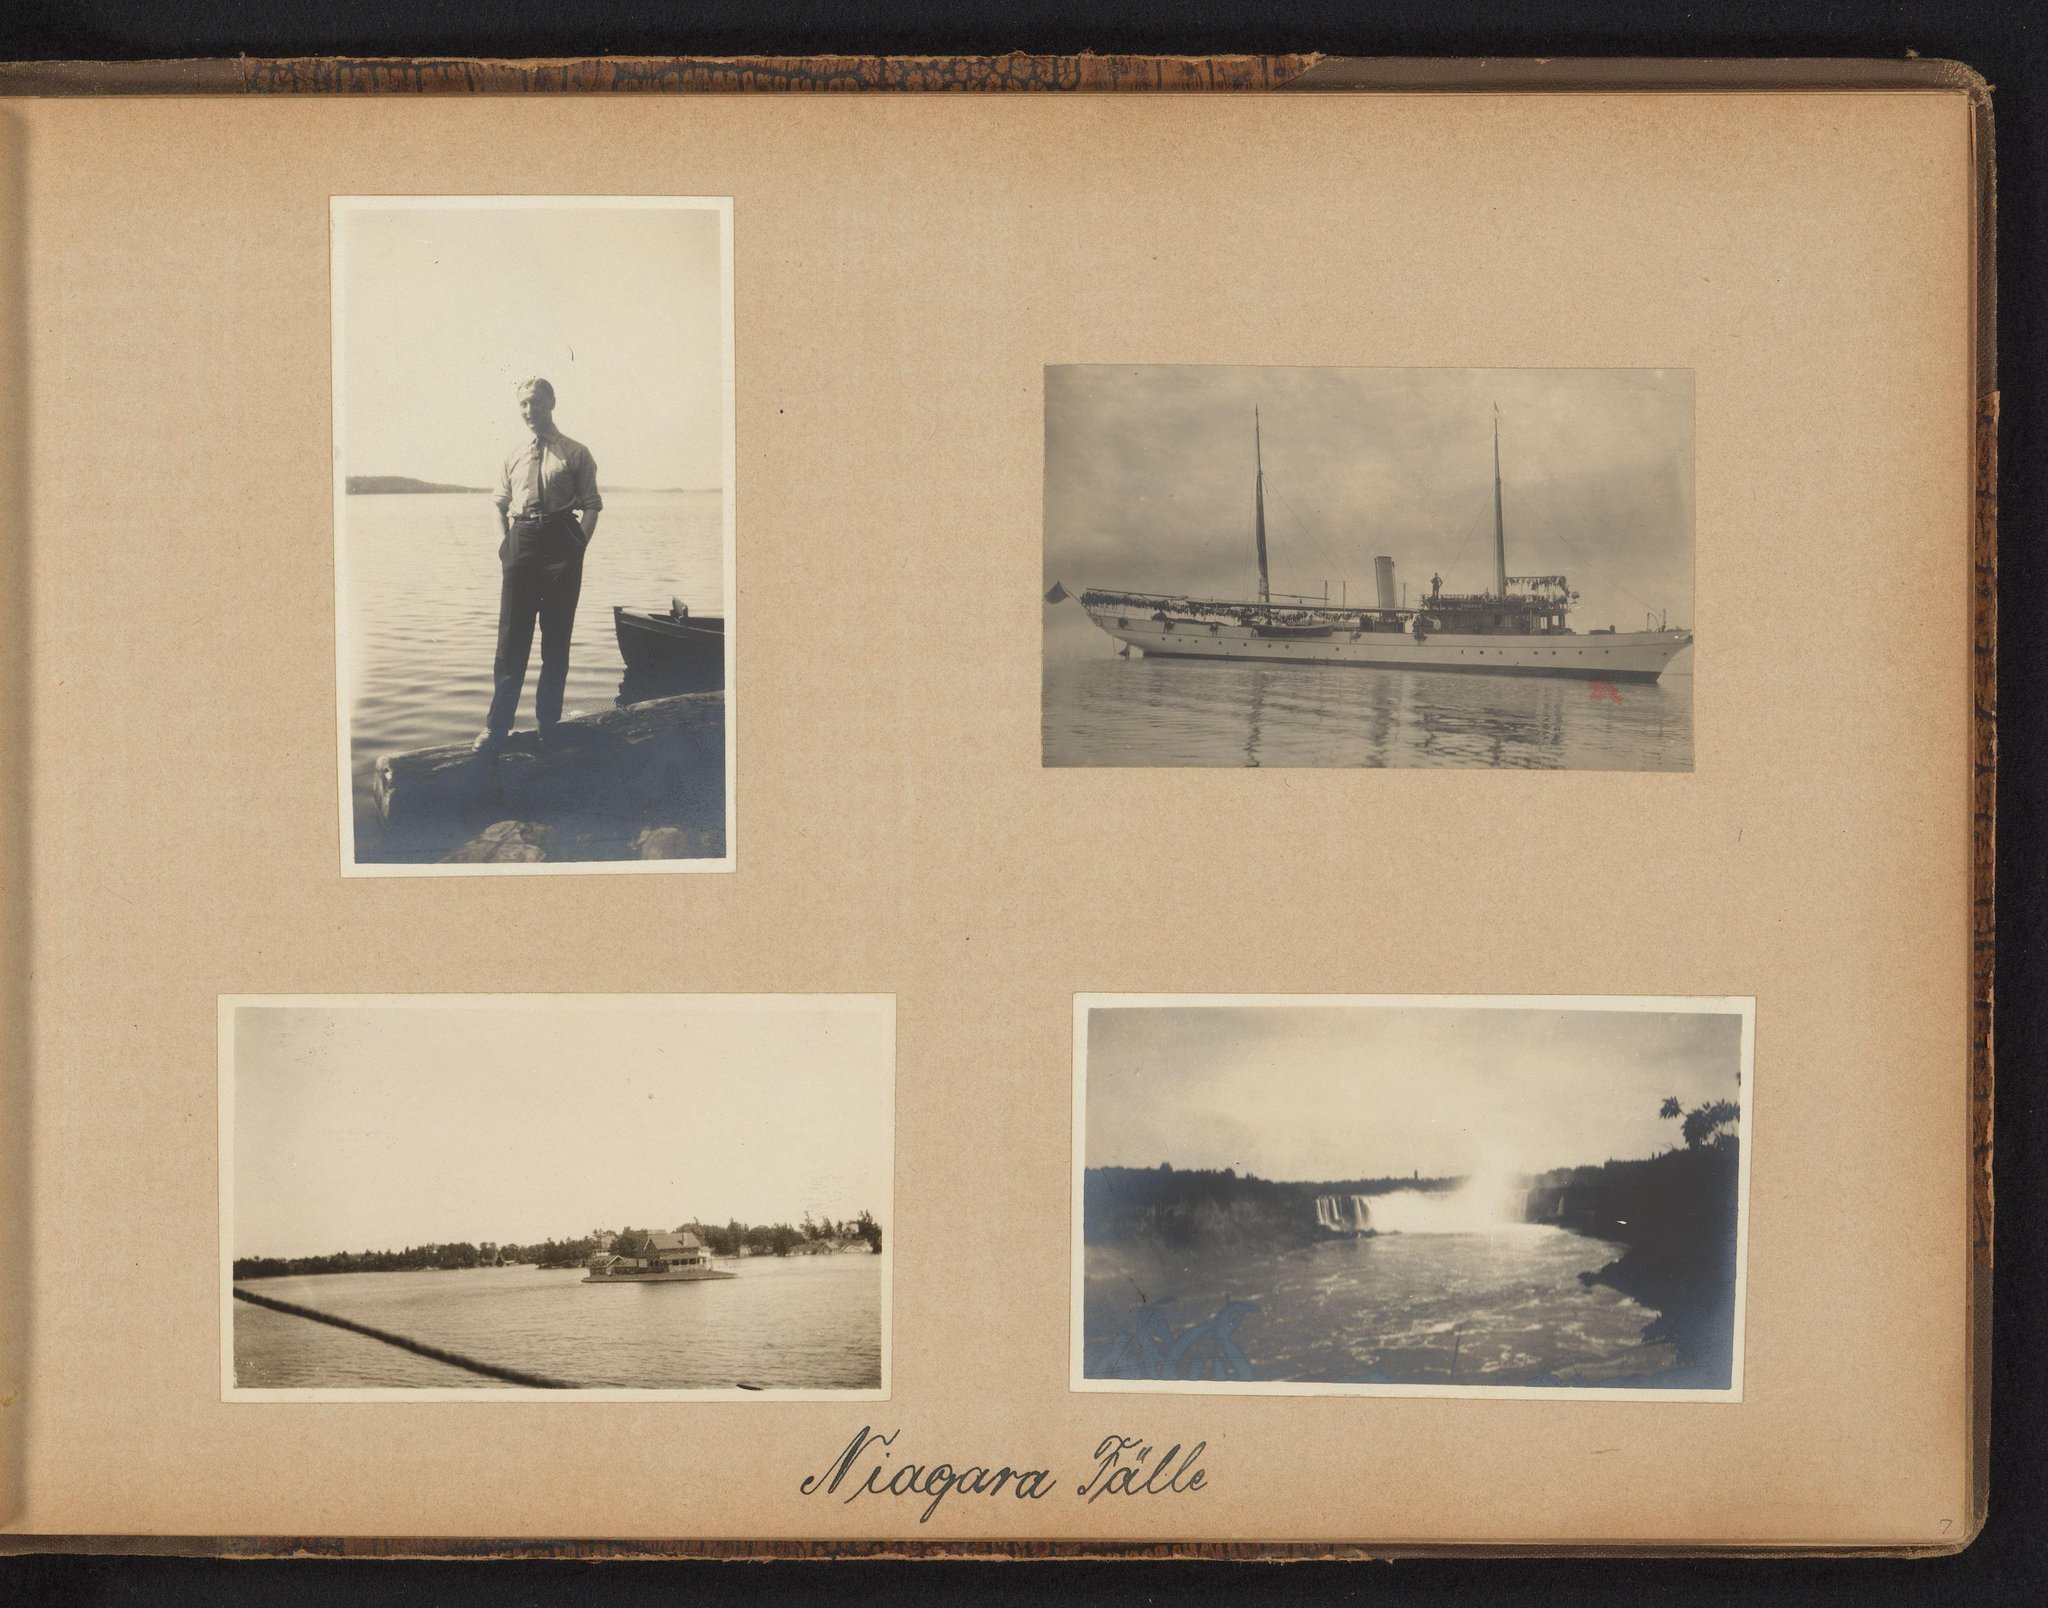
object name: album leaf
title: Niagarawatervallen, portret en schip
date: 1909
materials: paper, photographic support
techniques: gelatin silver print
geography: united states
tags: willy moos, steamsailer, river, waterfall, historical persons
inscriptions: inscription: ‘Niagara Fälle’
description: Albumblad met vier foto's van de Niagarawatervallen, een portret van Willy Moos, een huis aan de rivier en van een schip. Onderdeel van het fotoalbum van een reis van Willy Moos naar Canada en de Verenigde Staten in 1909.